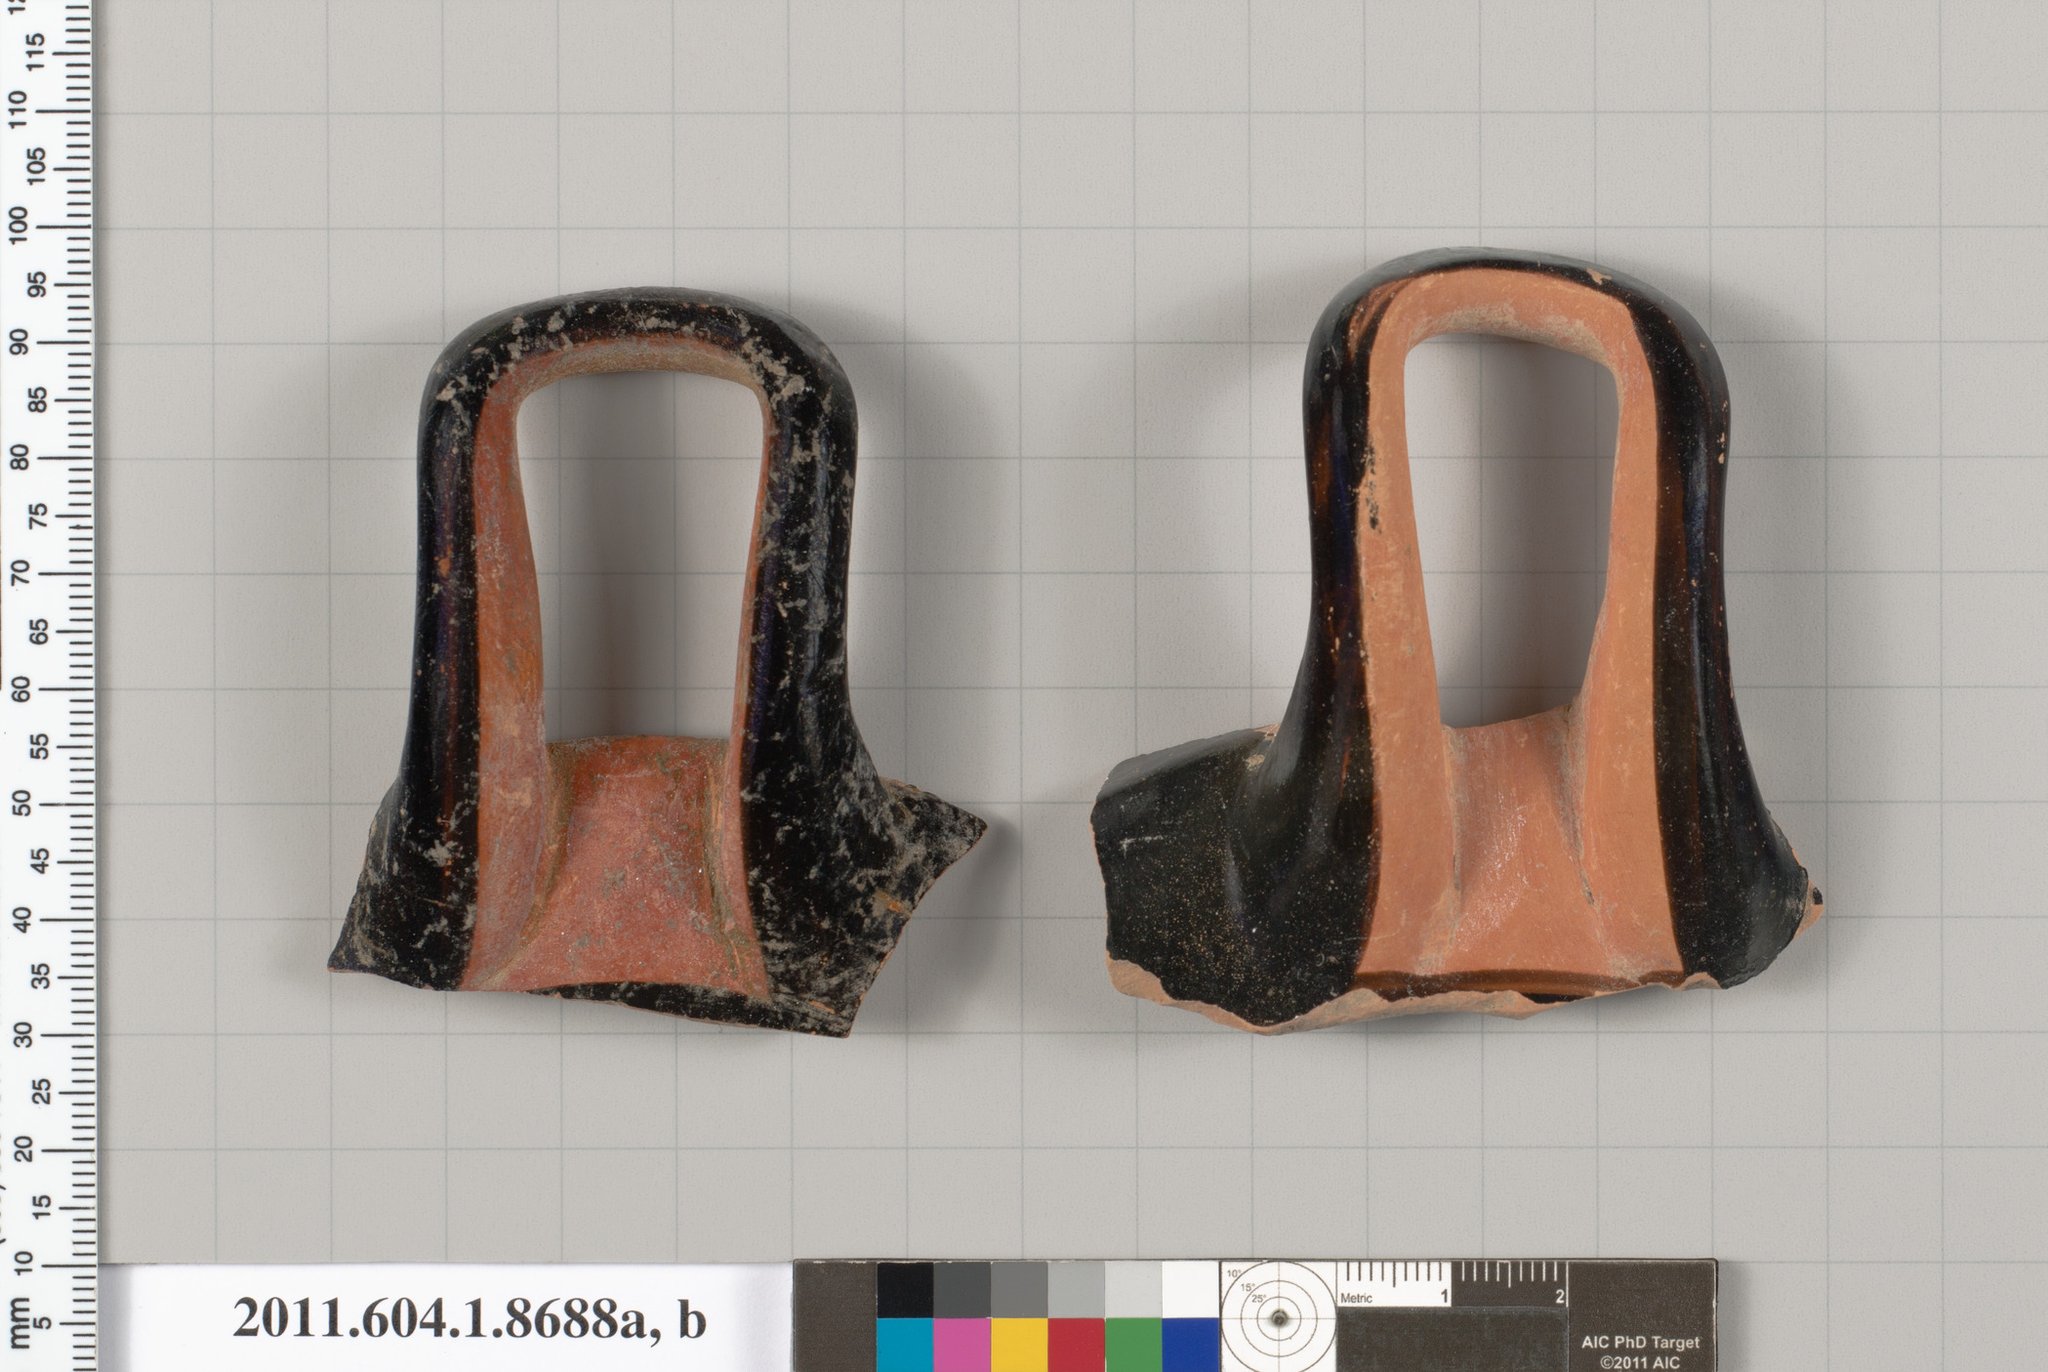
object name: kylix fragment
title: Terracotta fragments of stemless kylikes (drinking cups)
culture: greek, attic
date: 470-450 BCE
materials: terracotta